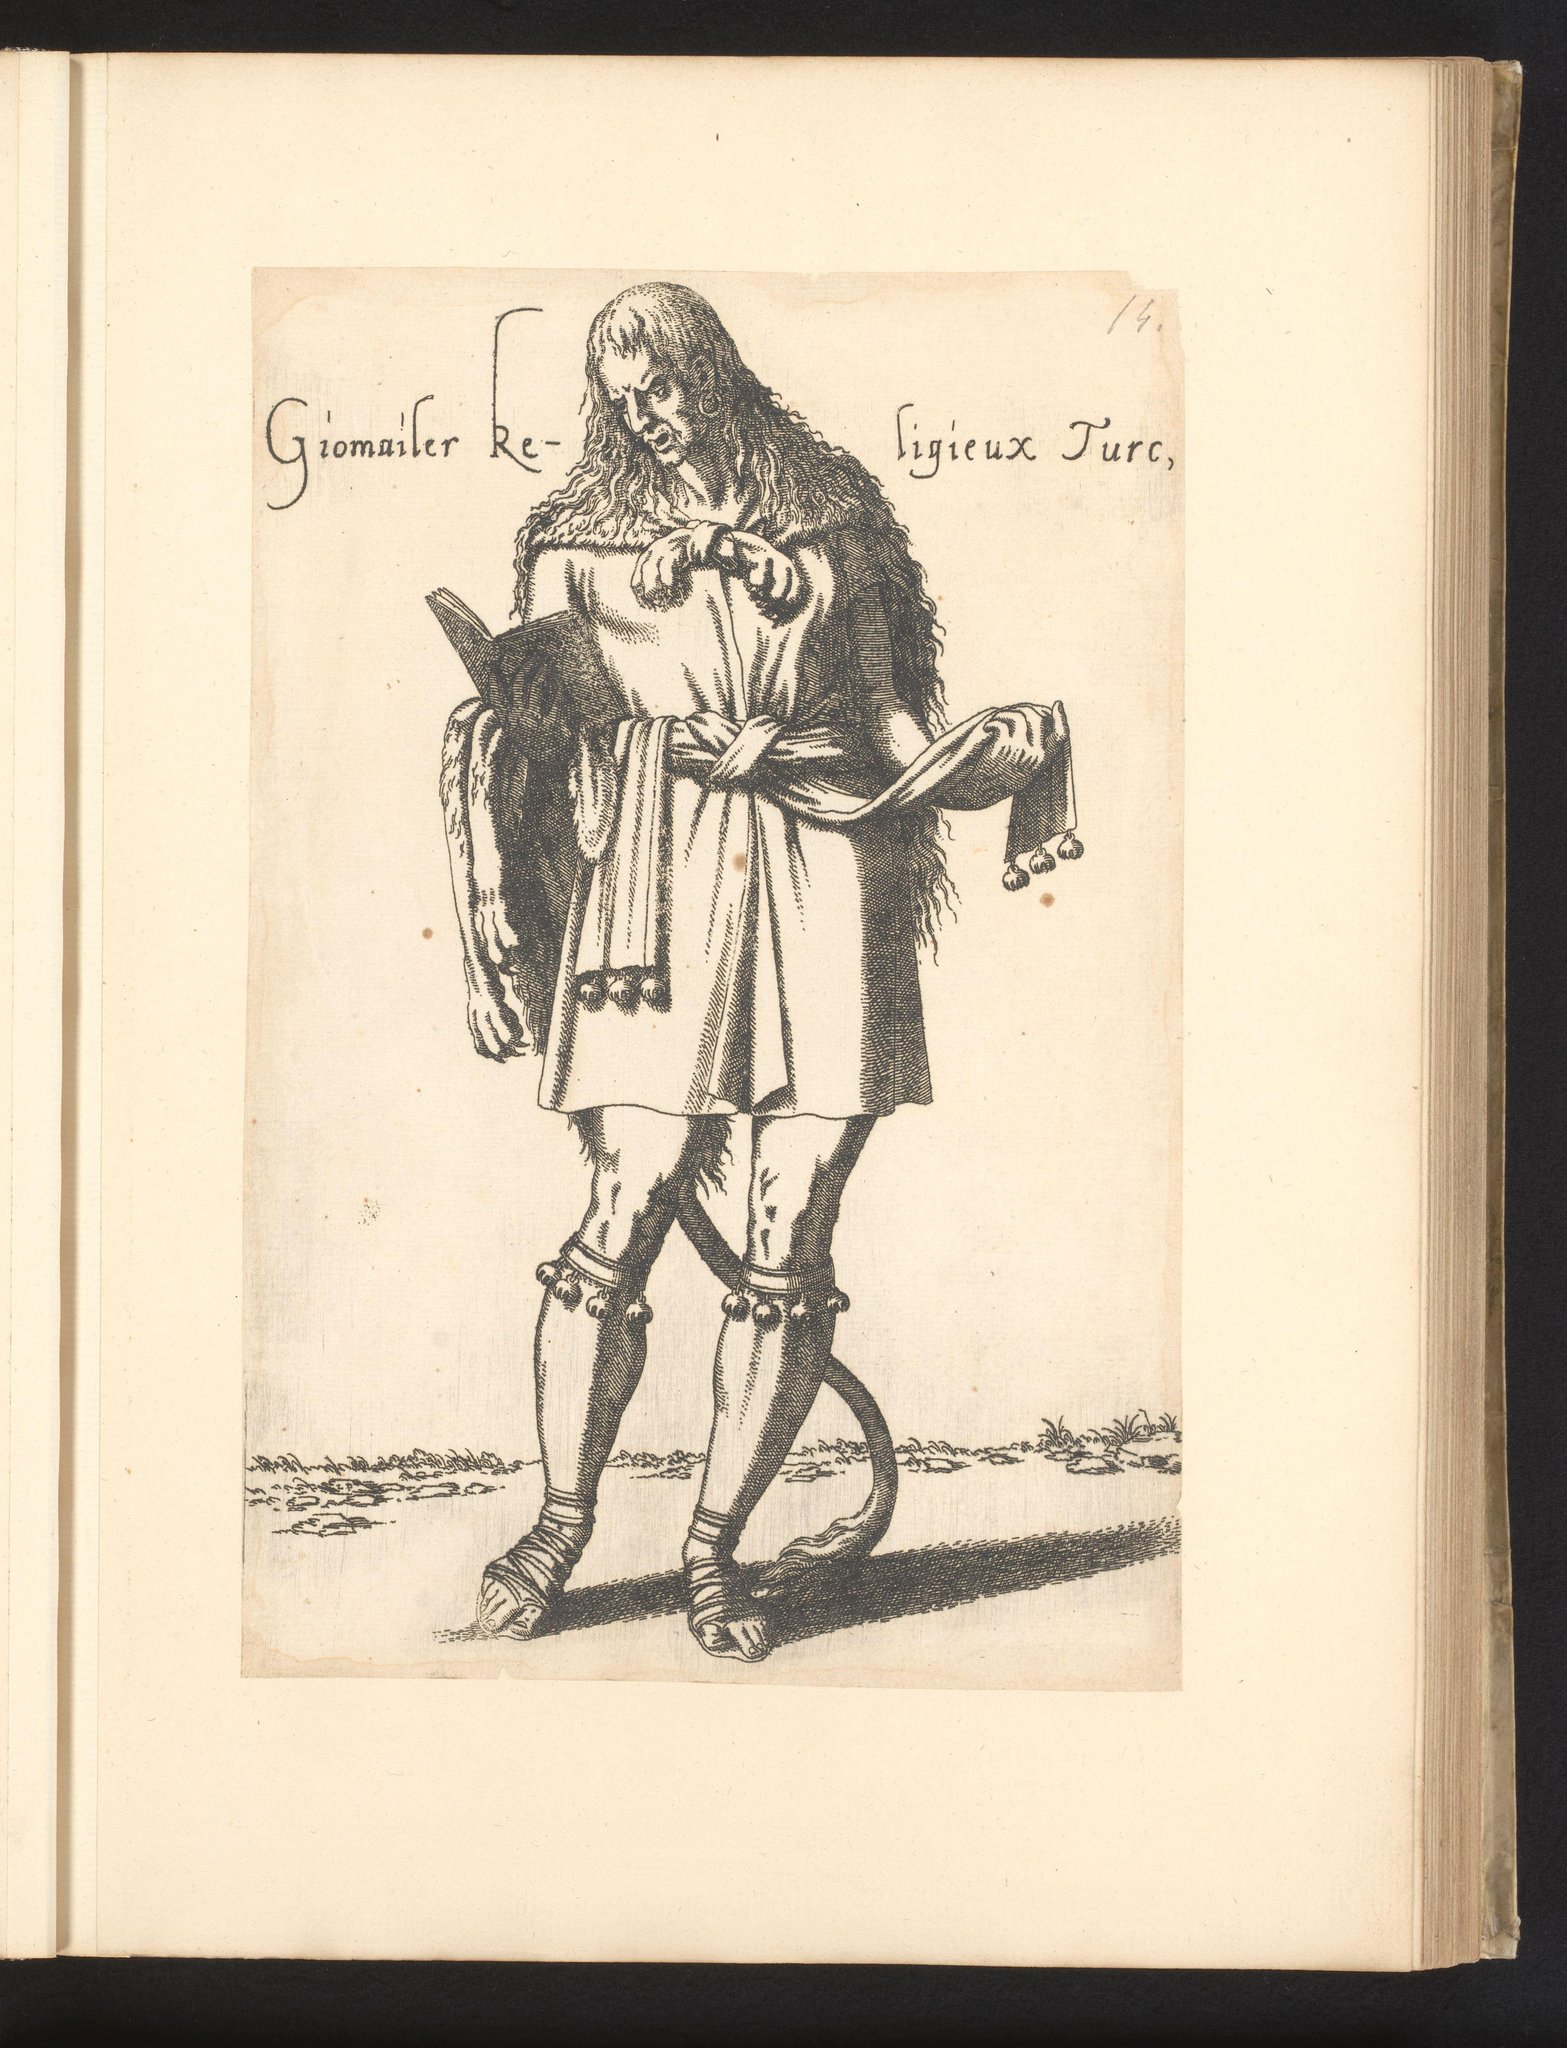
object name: book illustration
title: Turkse geestelijke van de orde der Giomailers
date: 1555-1568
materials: paper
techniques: etching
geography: lyon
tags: religious functionaries ~ non-christian religions, monk(s), friar(s), asiatic races and peoples: turks (+ costume)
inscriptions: collector's mark: Lugt 2228, collector's mark: Lugt 2760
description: Prent uit: Nicolay, Nicolas de. Les quatre premiers livres des navigations et pérégrinations orientales, de N. de Nicolay, (...) Avec les figures au naturel tant d'hommes que de femmes selon la diversité des nations, & de leur port, maintien & habitz. Lyon: Guillaume (I) Rouille, 1568.